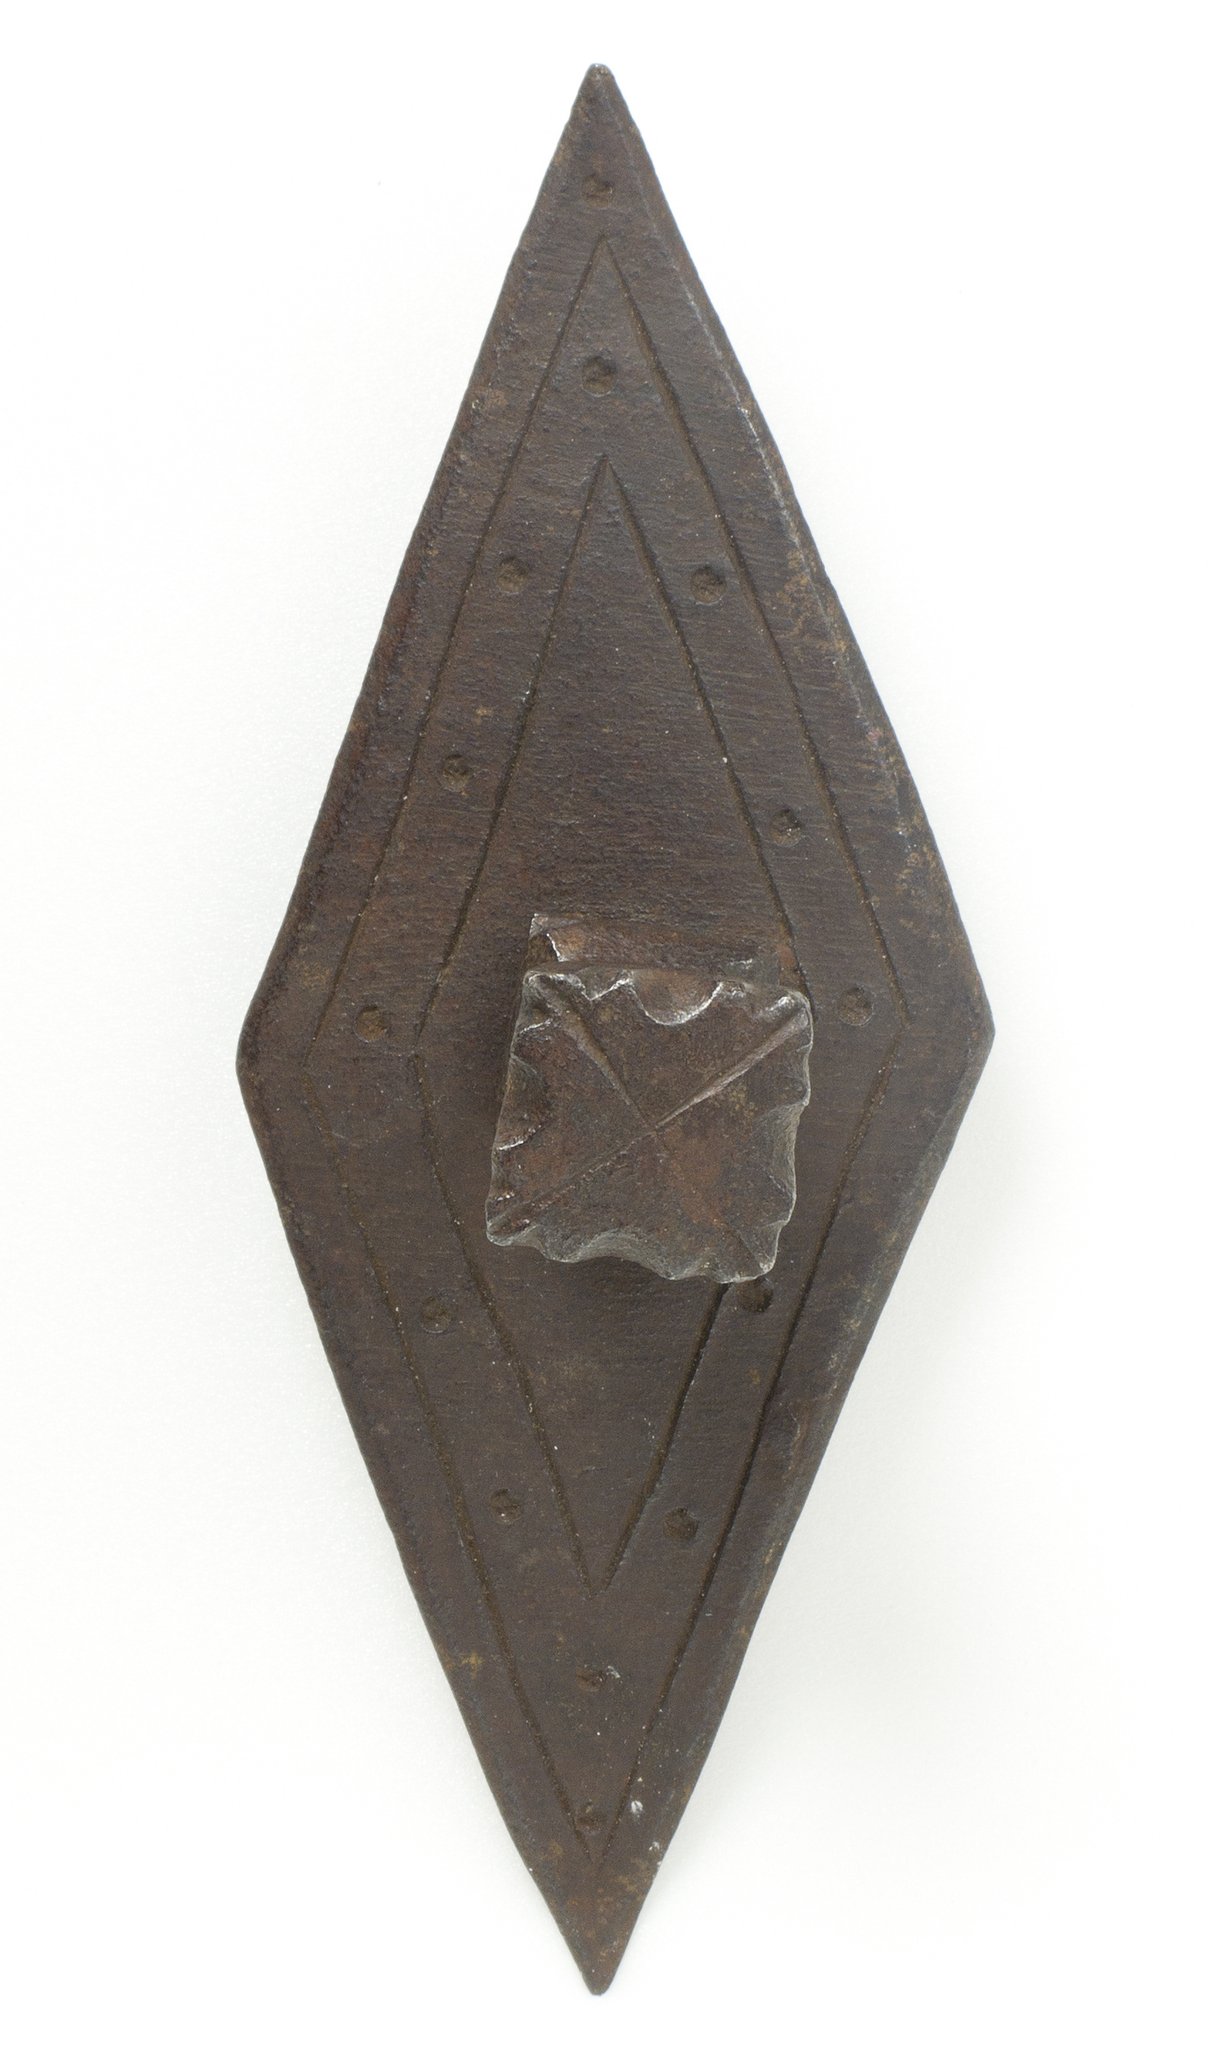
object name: plate and nail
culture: european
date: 1401-1600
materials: iron